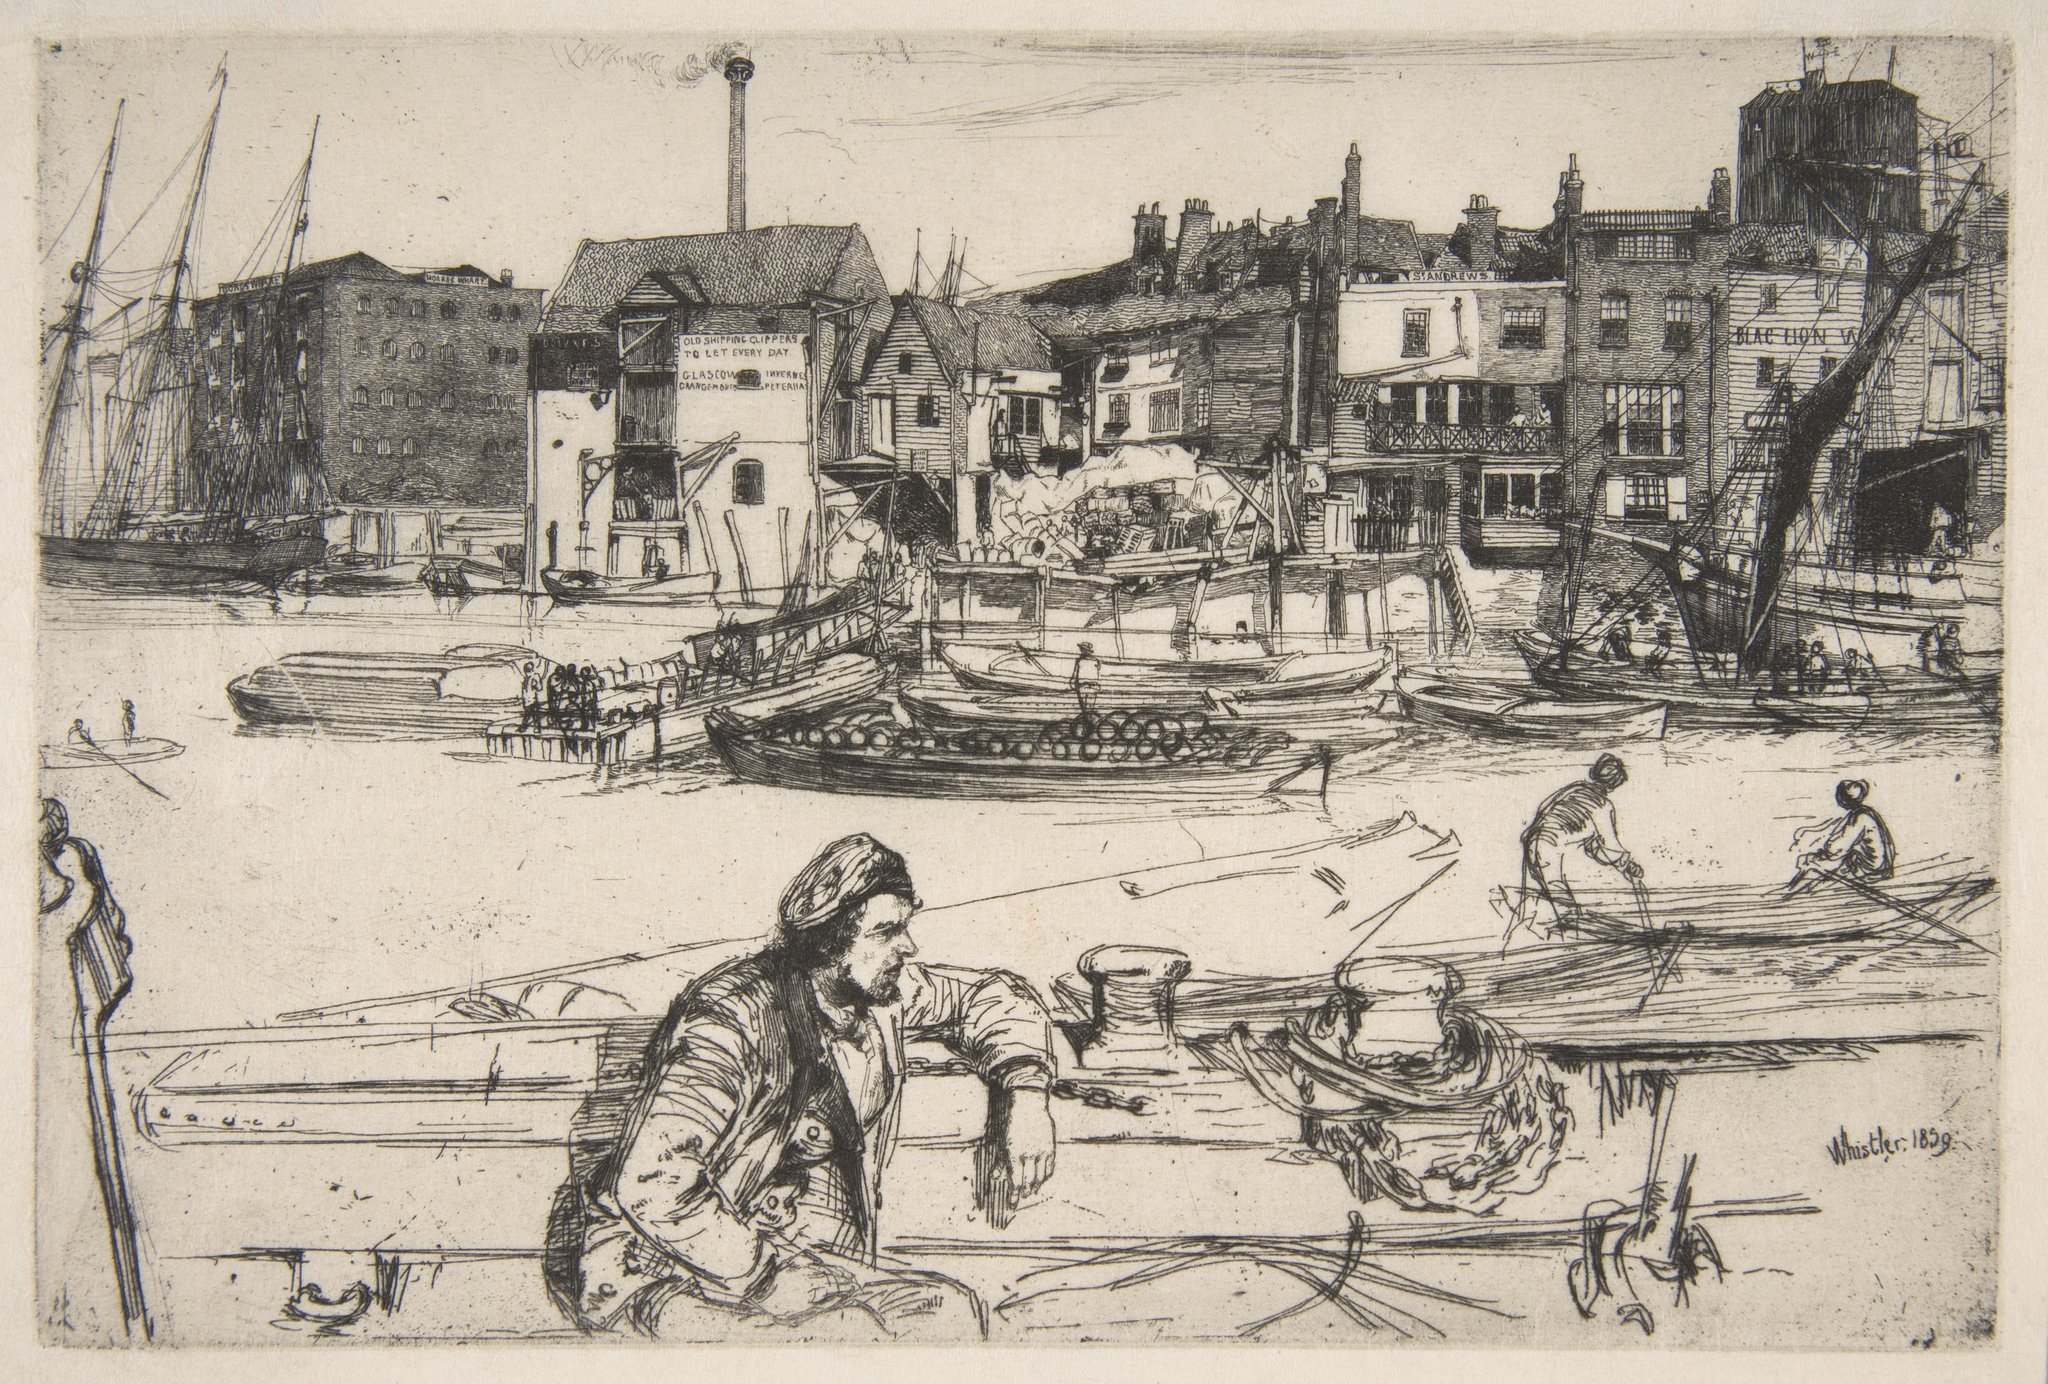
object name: print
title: Black Lion Wharf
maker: james mcneill whistler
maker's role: artist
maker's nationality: american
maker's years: 1834-1903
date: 1859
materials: ink, paper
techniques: etching, printing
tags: buildings,men,boats